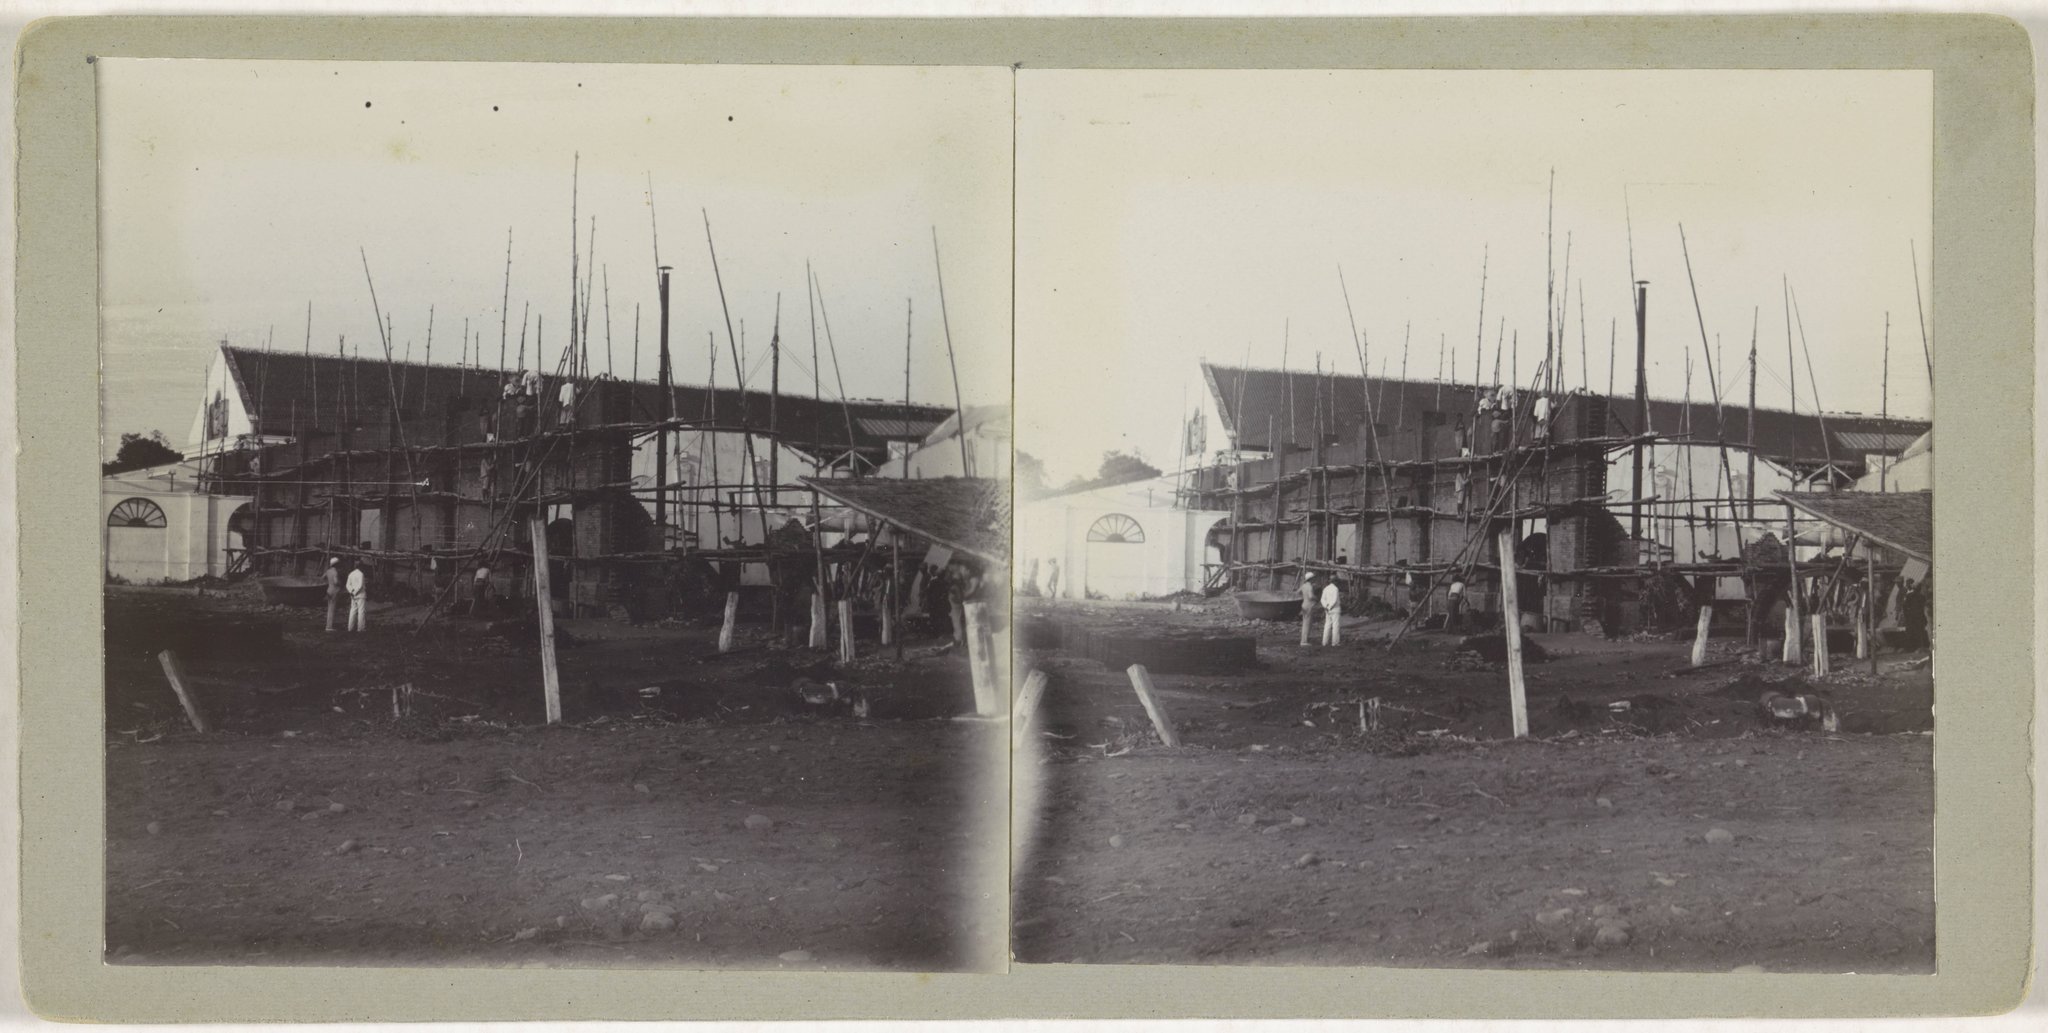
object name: stereograph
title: Verbouwing Soemberkareng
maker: Anonymous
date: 1905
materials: cardboard, paper, photographic support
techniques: albumen print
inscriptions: inscription: ‘Verbouwing Soemberkareng op 31 October '05’